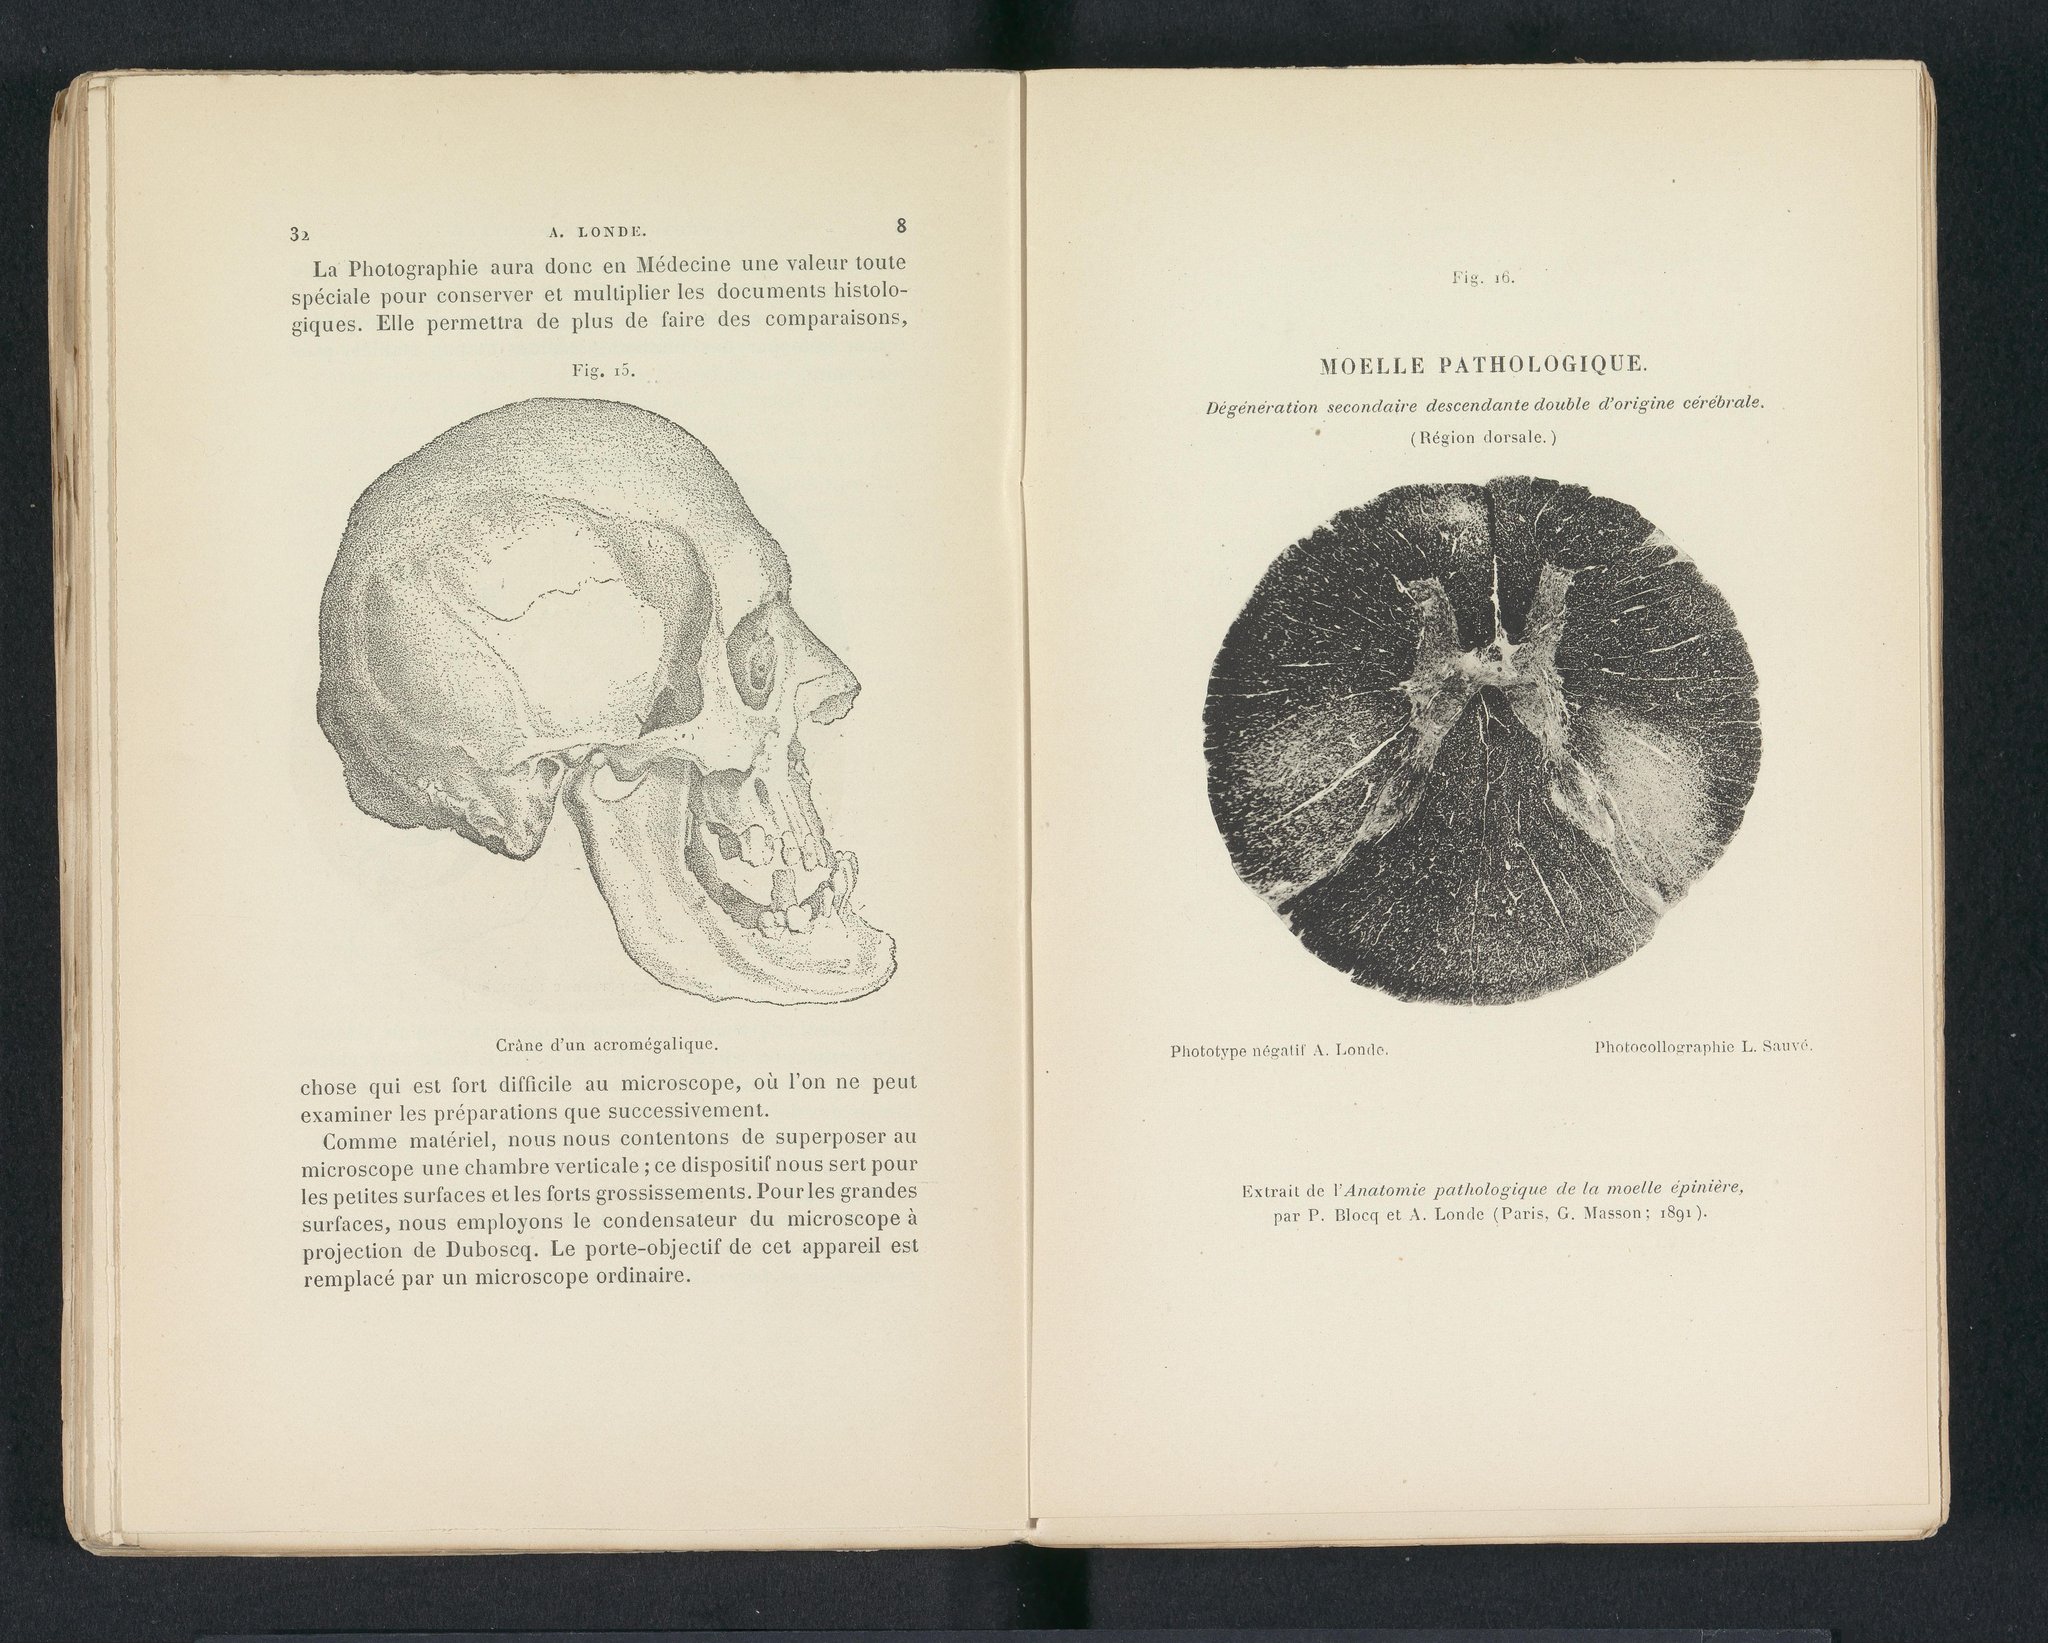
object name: photomechanical print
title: Moelle pathologique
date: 1883-1893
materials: paper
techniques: photograph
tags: spine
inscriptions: number: ‘Fig. 16.’